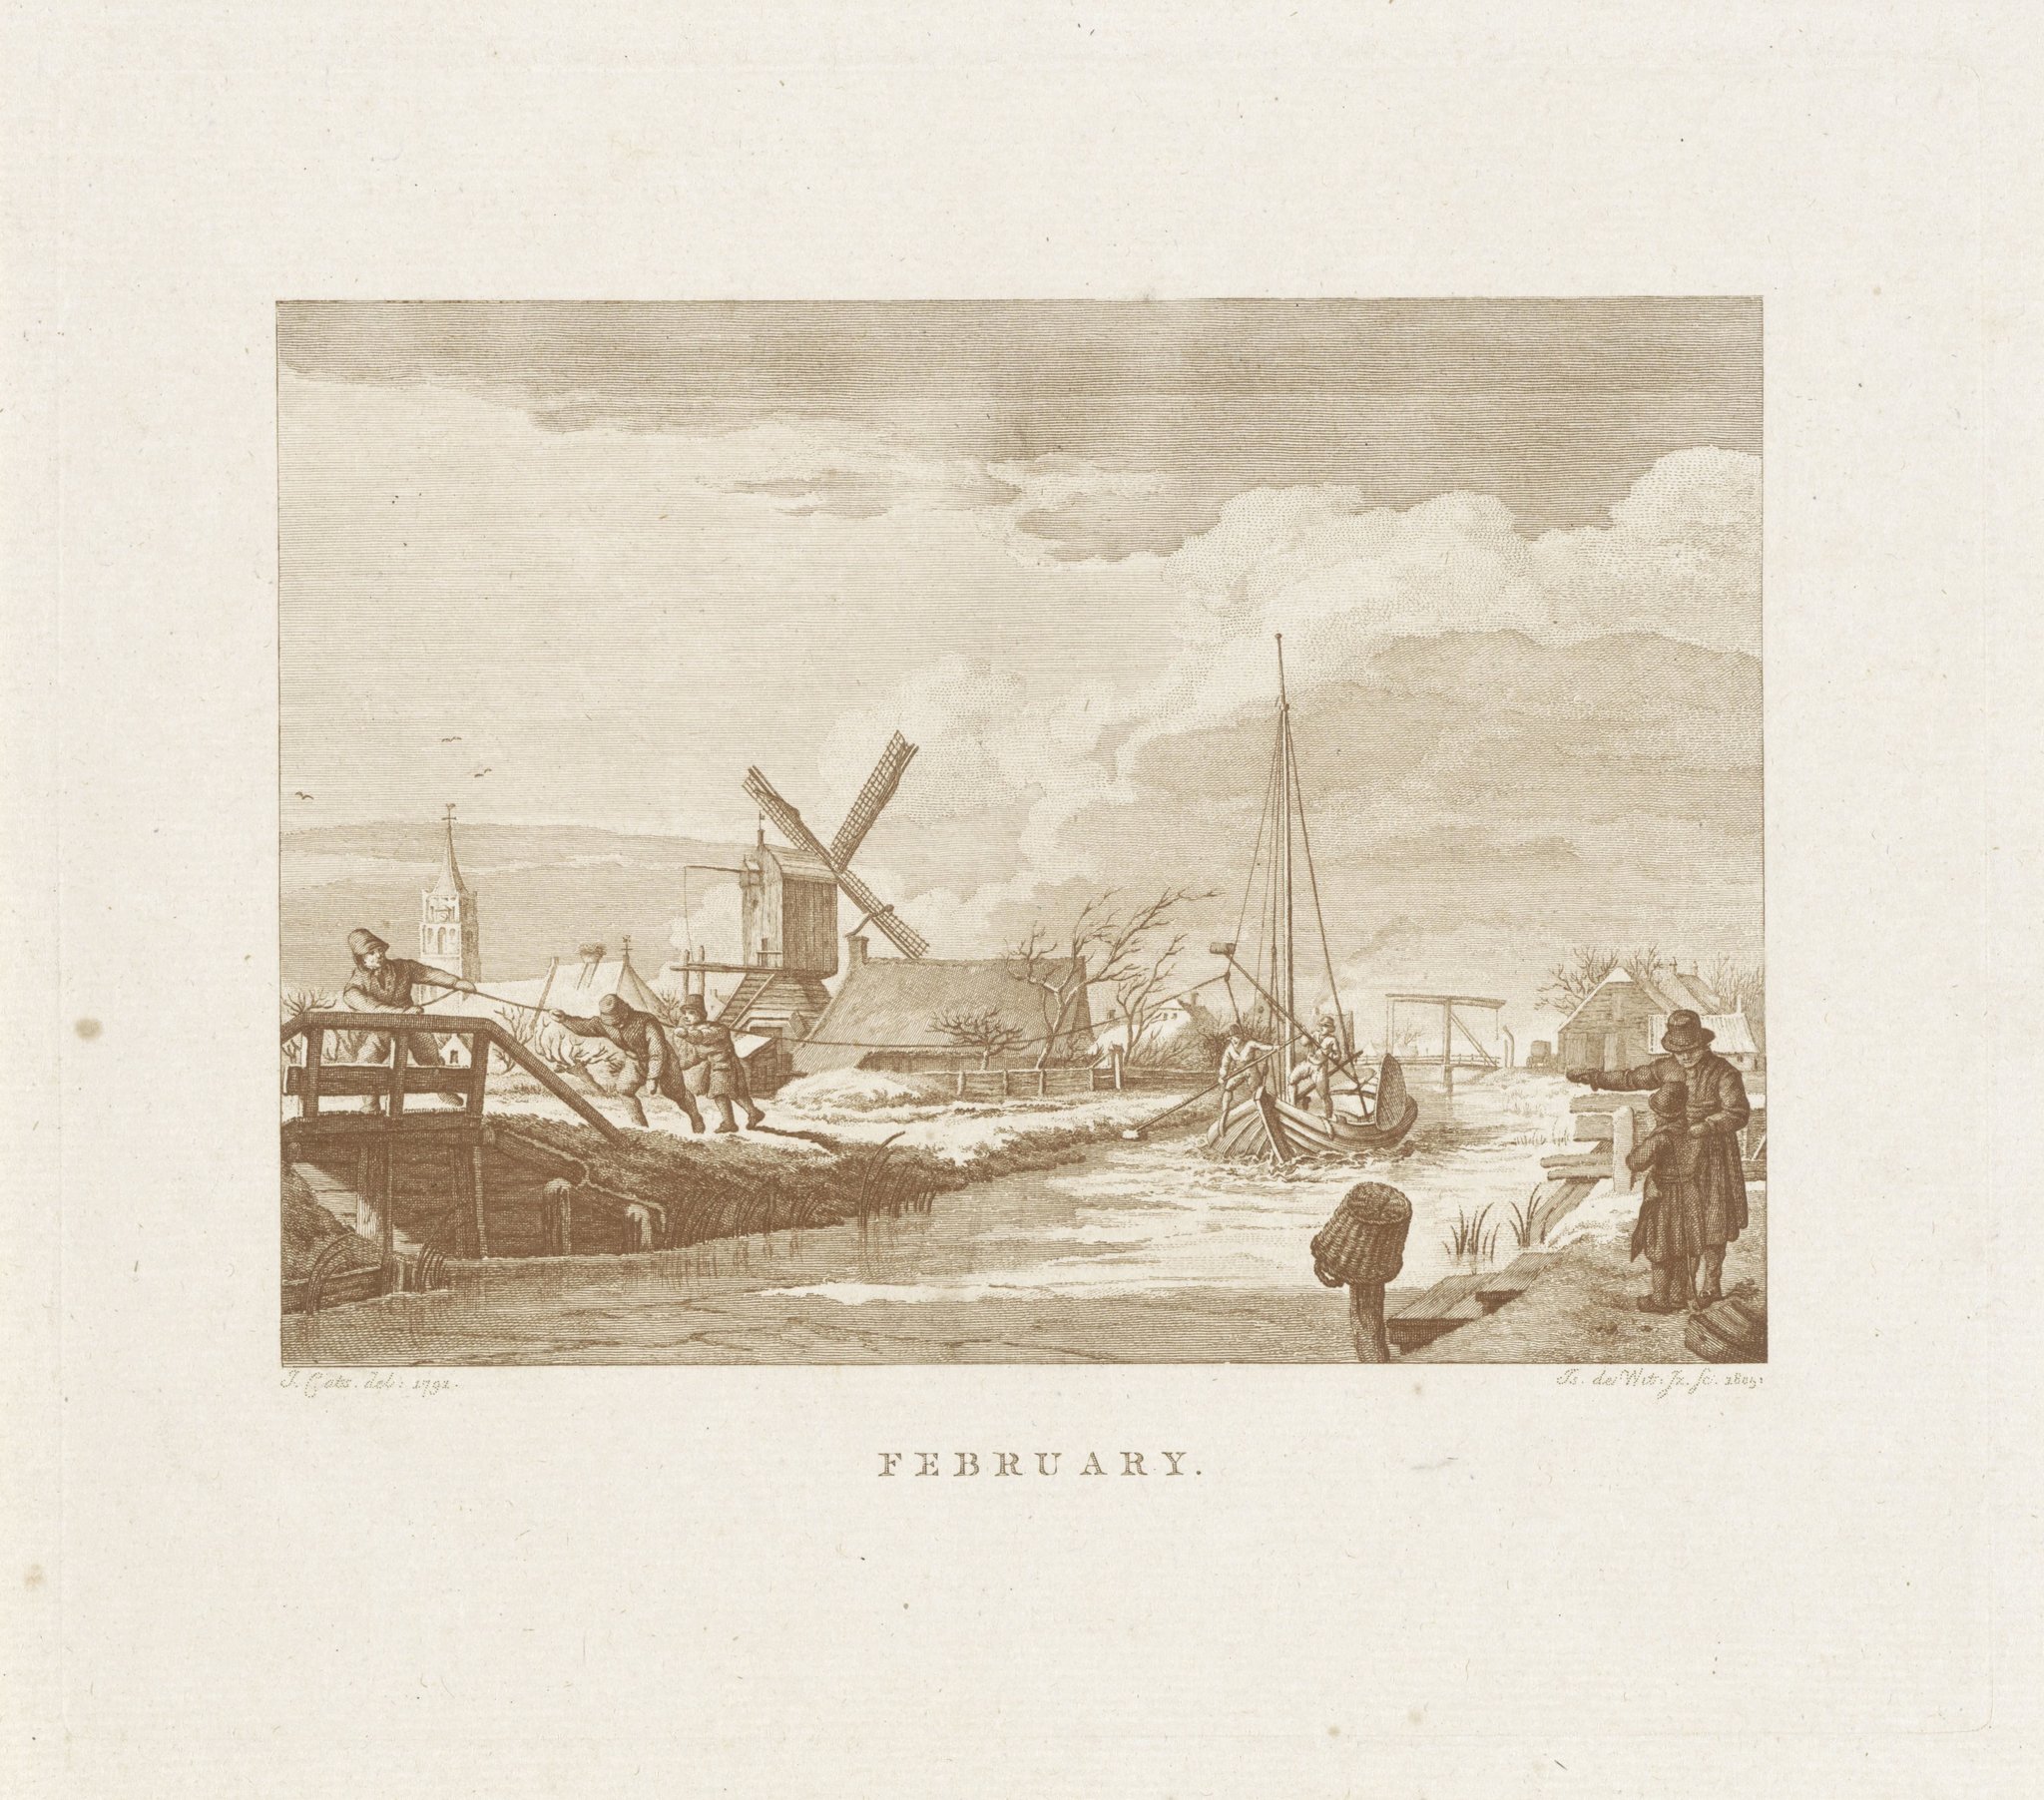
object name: print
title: De twaalf maanden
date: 1805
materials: paper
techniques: etching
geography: haarlem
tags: february and its 'labours' (+ with scenes showing human occupations ~ seasons and months), tow-boat, towing-barge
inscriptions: collector's mark: Lugt 2228